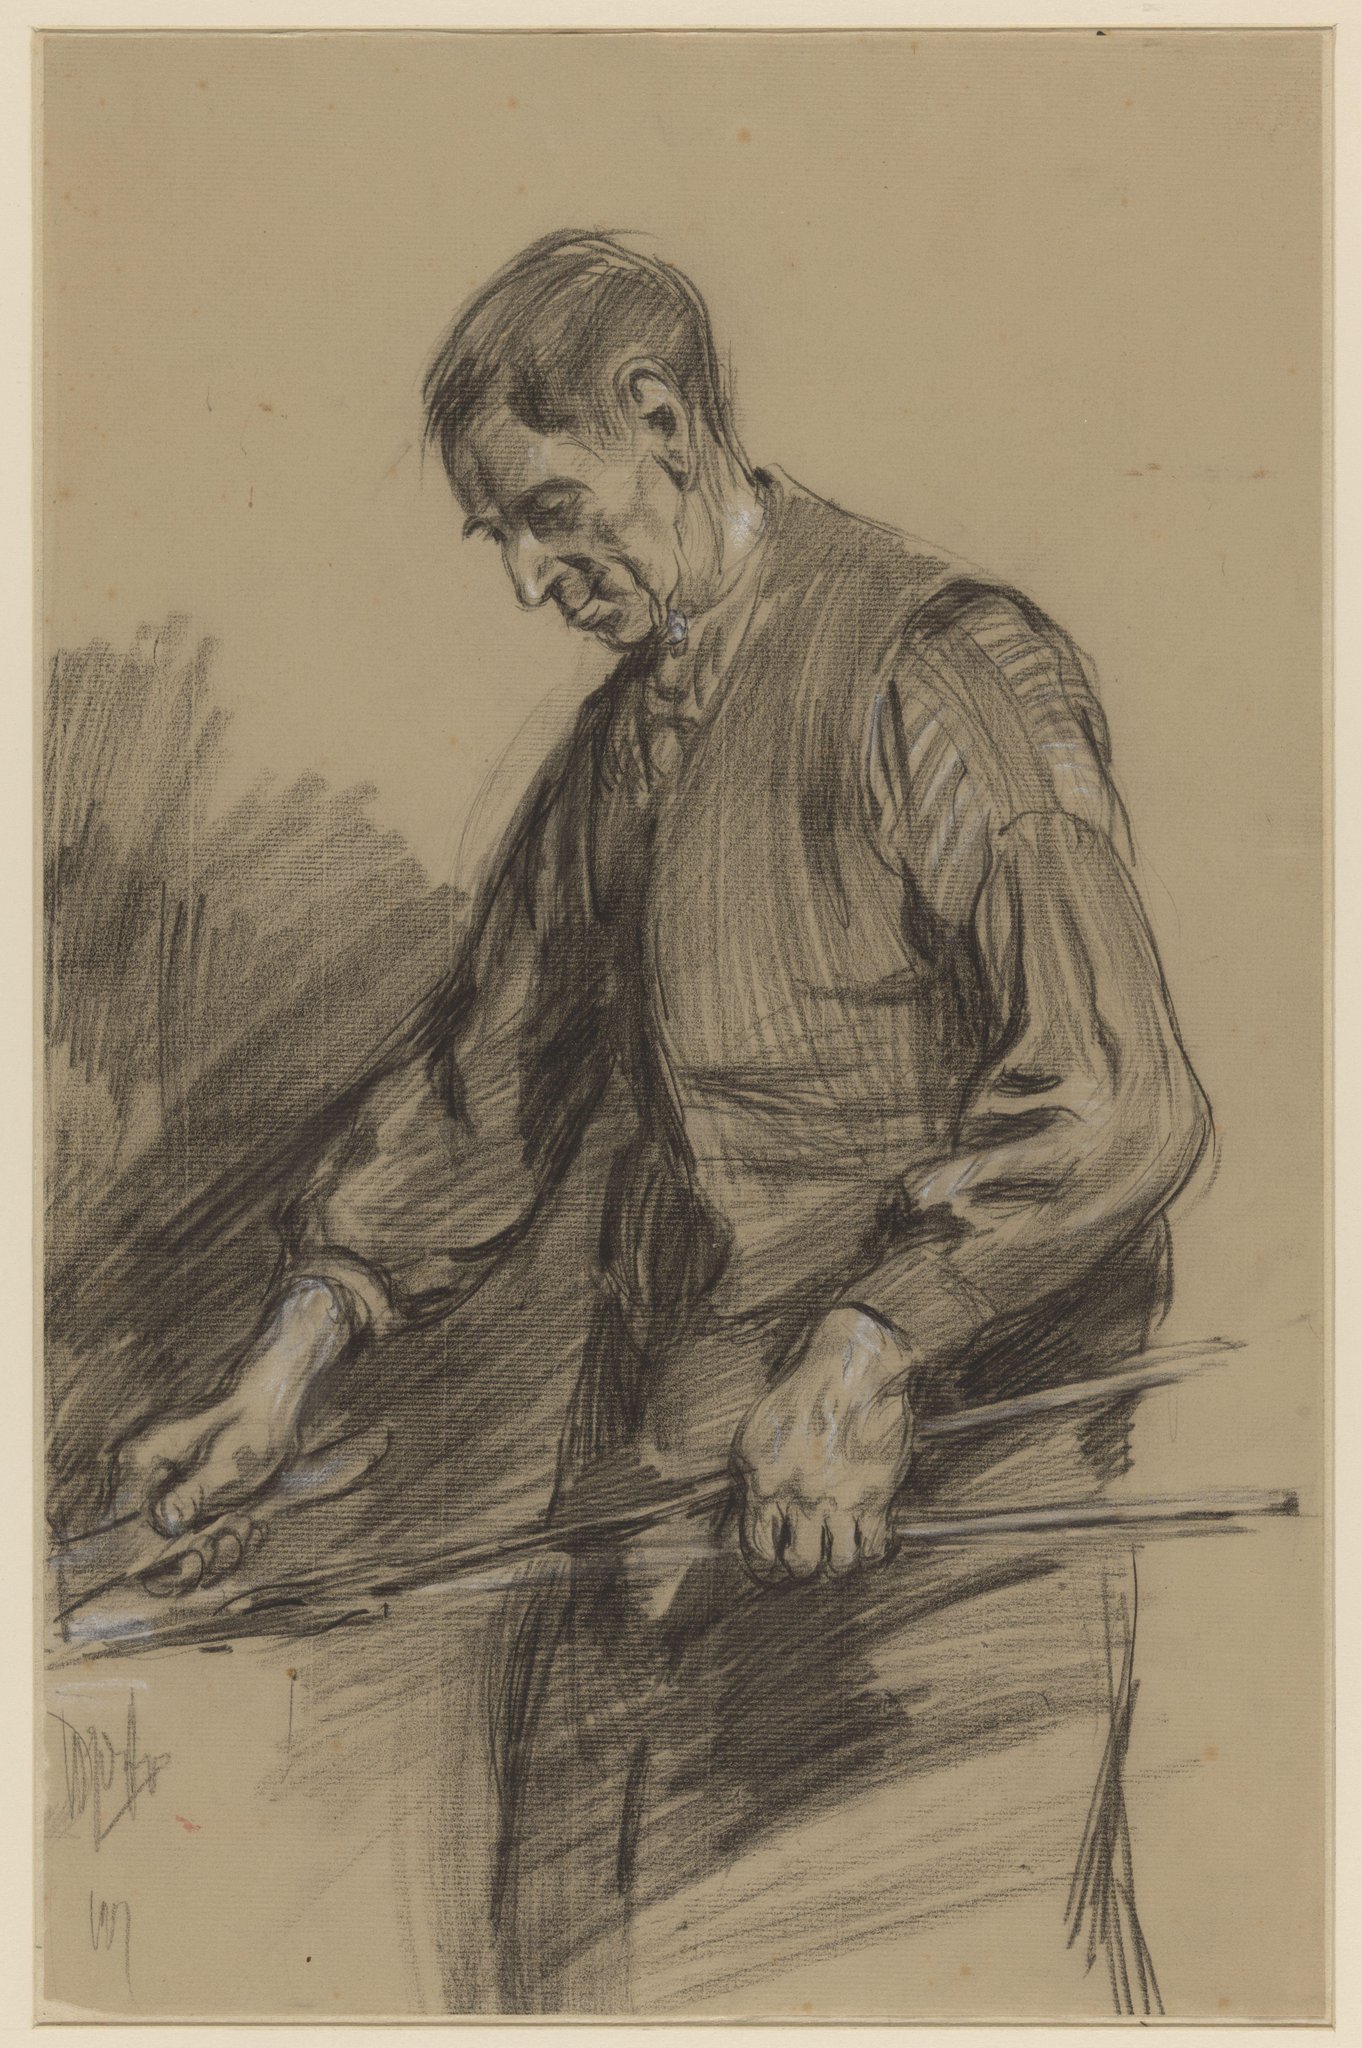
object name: drawing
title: Smid in zijn werkplaats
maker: waalko jans dingemans (i)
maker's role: draughtsman, print maker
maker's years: 1873-1925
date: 1917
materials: chalk, paper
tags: smith, blacksmith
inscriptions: collector's mark: Lugt 2228